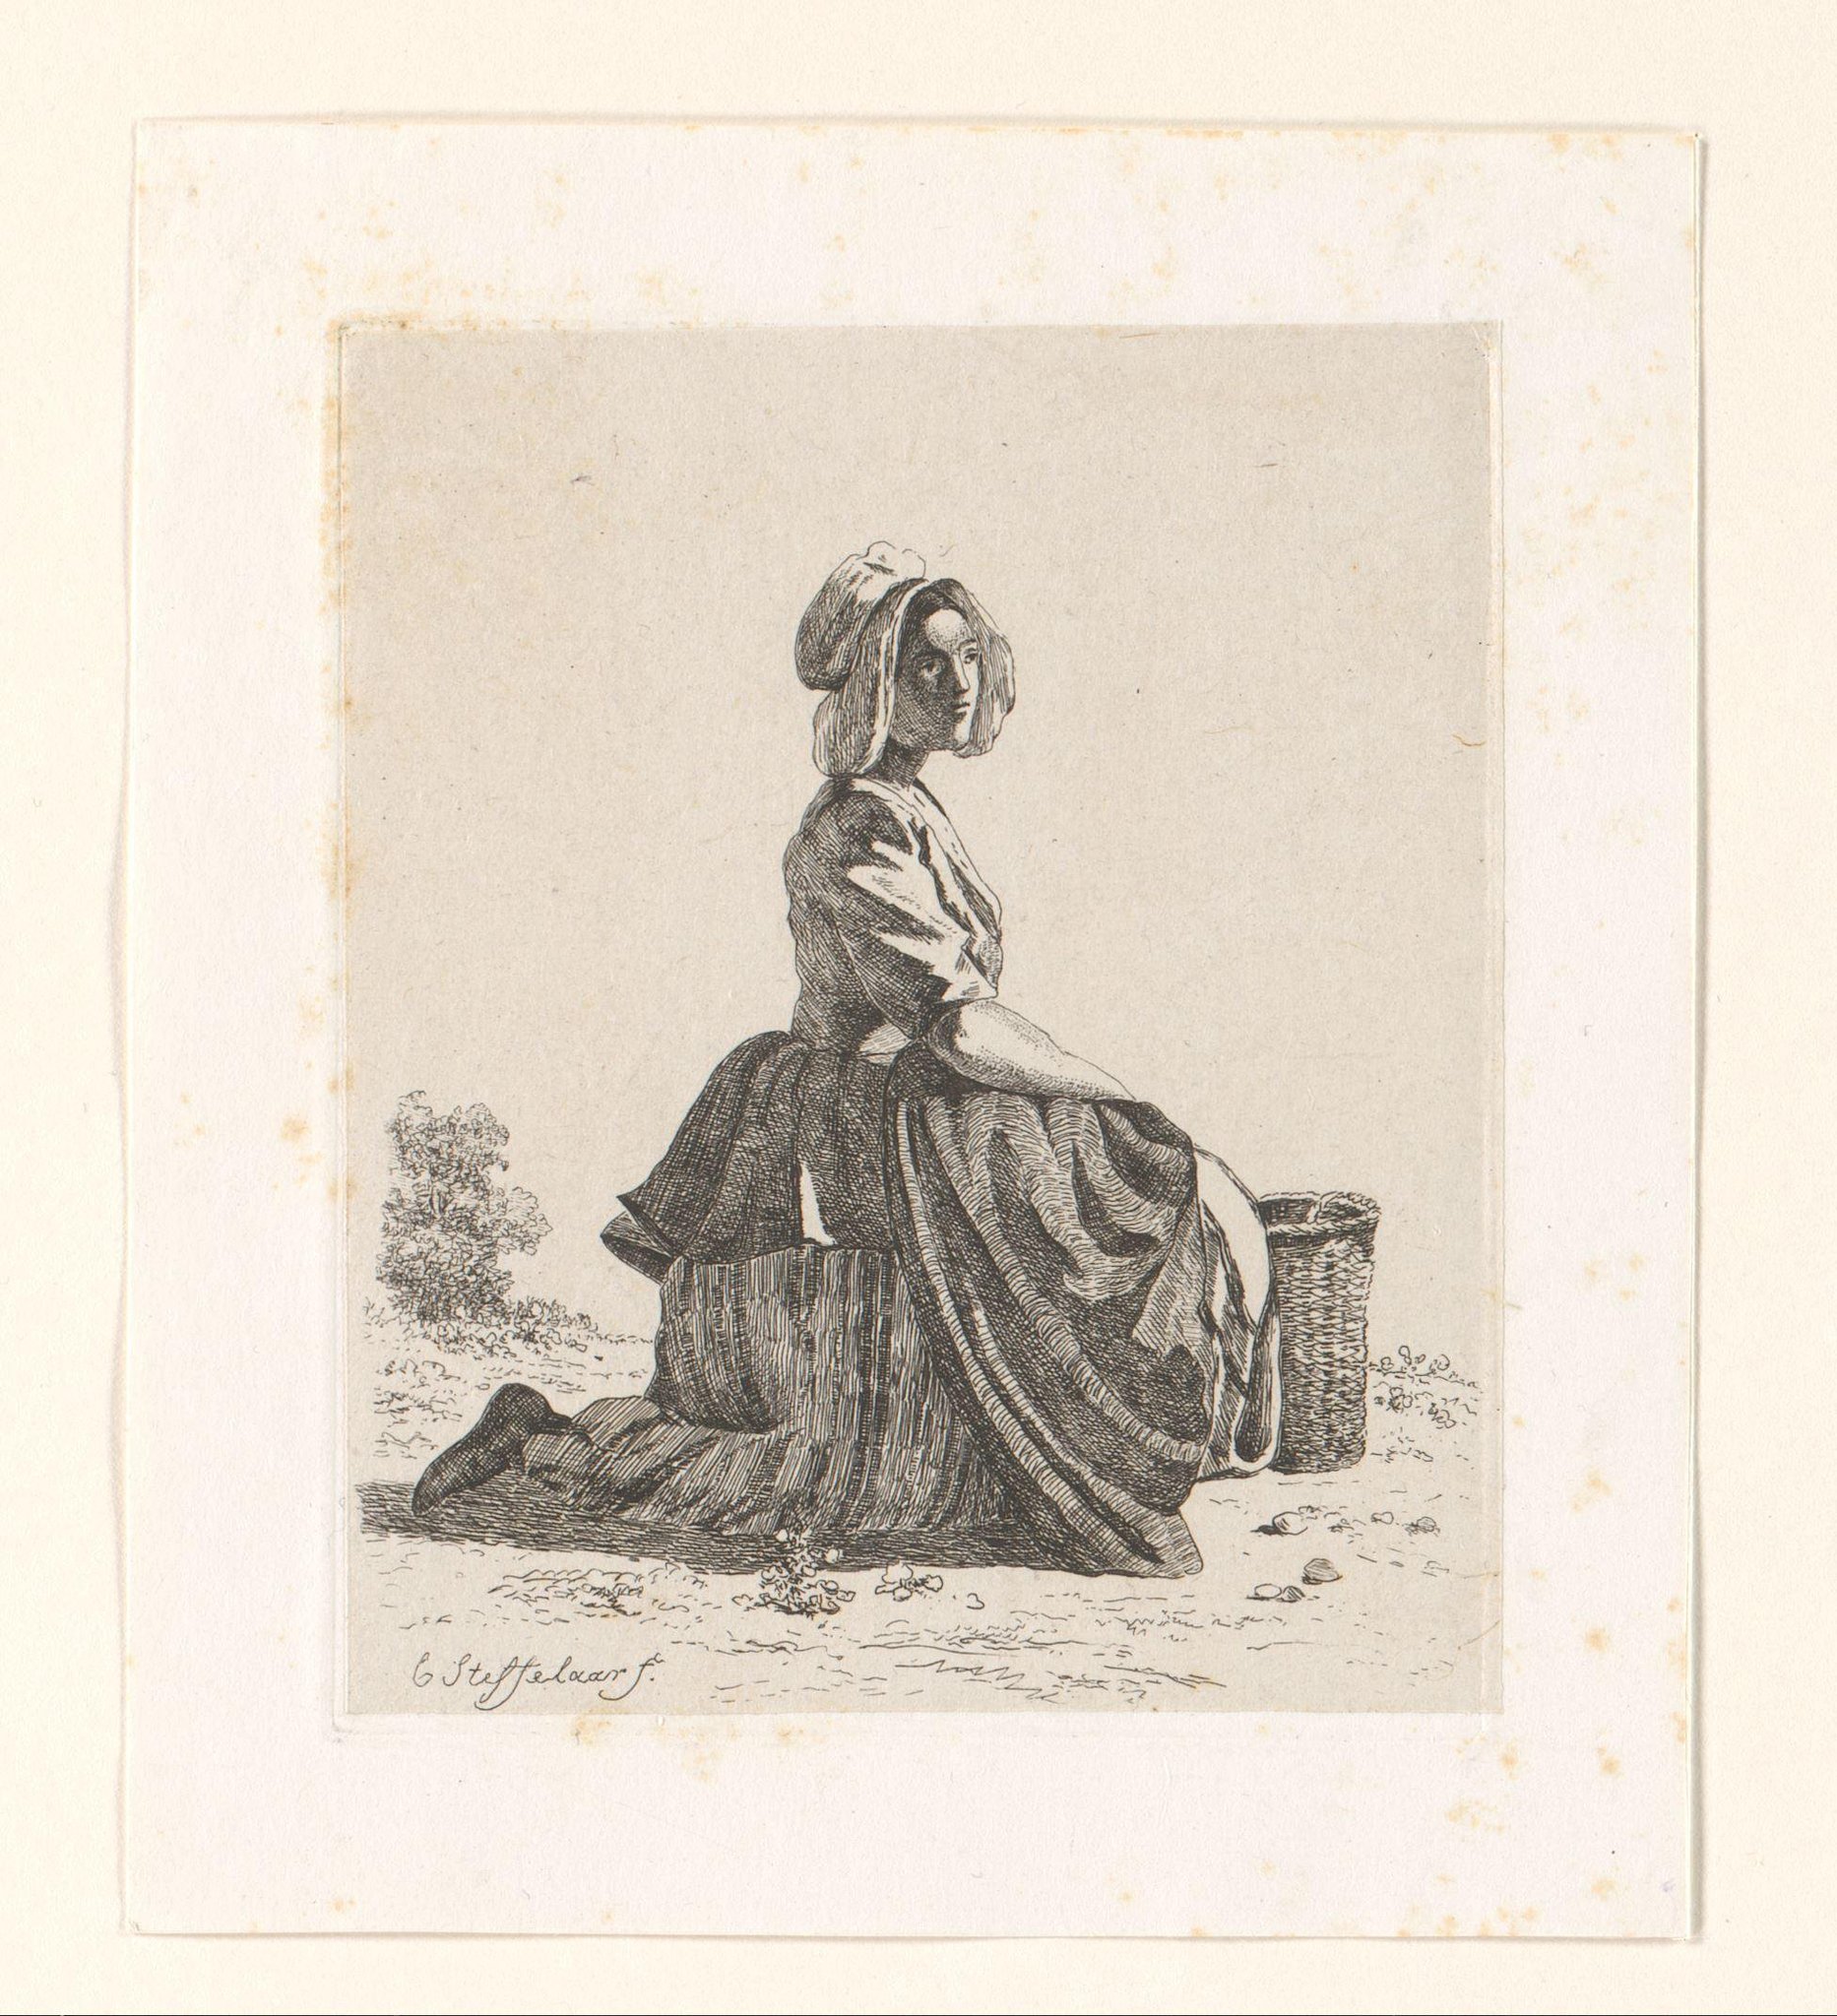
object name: print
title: Knielende boerin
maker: cornelis steffelaar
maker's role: draughtsman, painter, print maker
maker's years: 1797-1861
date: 1807-1861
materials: paper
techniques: etching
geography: amsterdam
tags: kneeling figure - aa - female human figure, farmers - aa - female farmer, farmer's wife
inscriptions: collector's mark: Lugt 2228, number: ‘30’, collector's mark: Lugt 1485